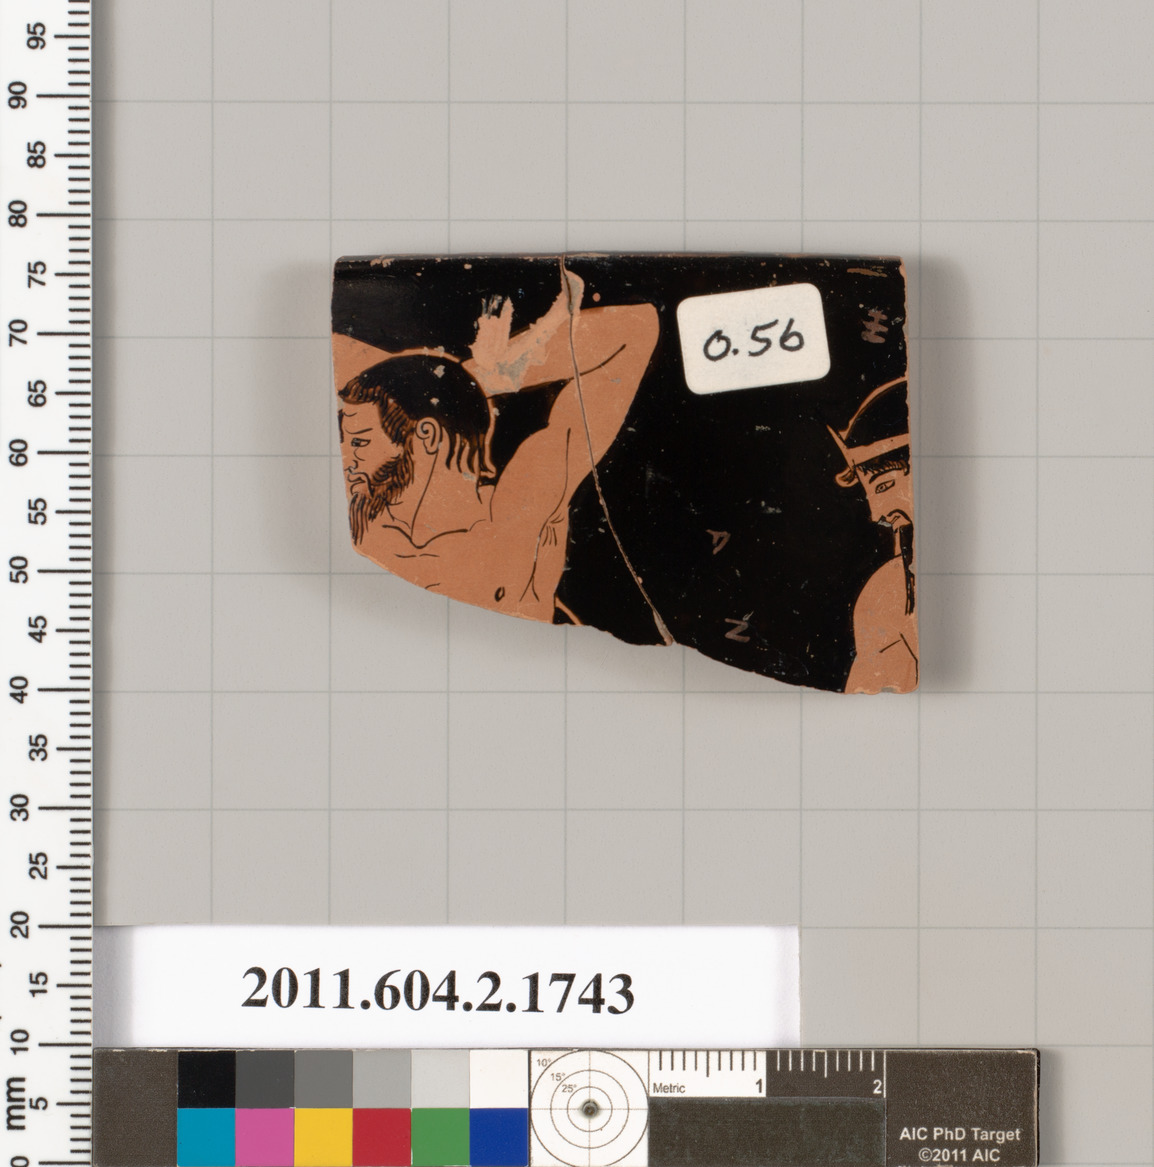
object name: skyphos fragment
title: Terracotta rim fragment of a skyphos (deep drinking cup)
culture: greek, attic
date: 480-470 BCE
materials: terracotta